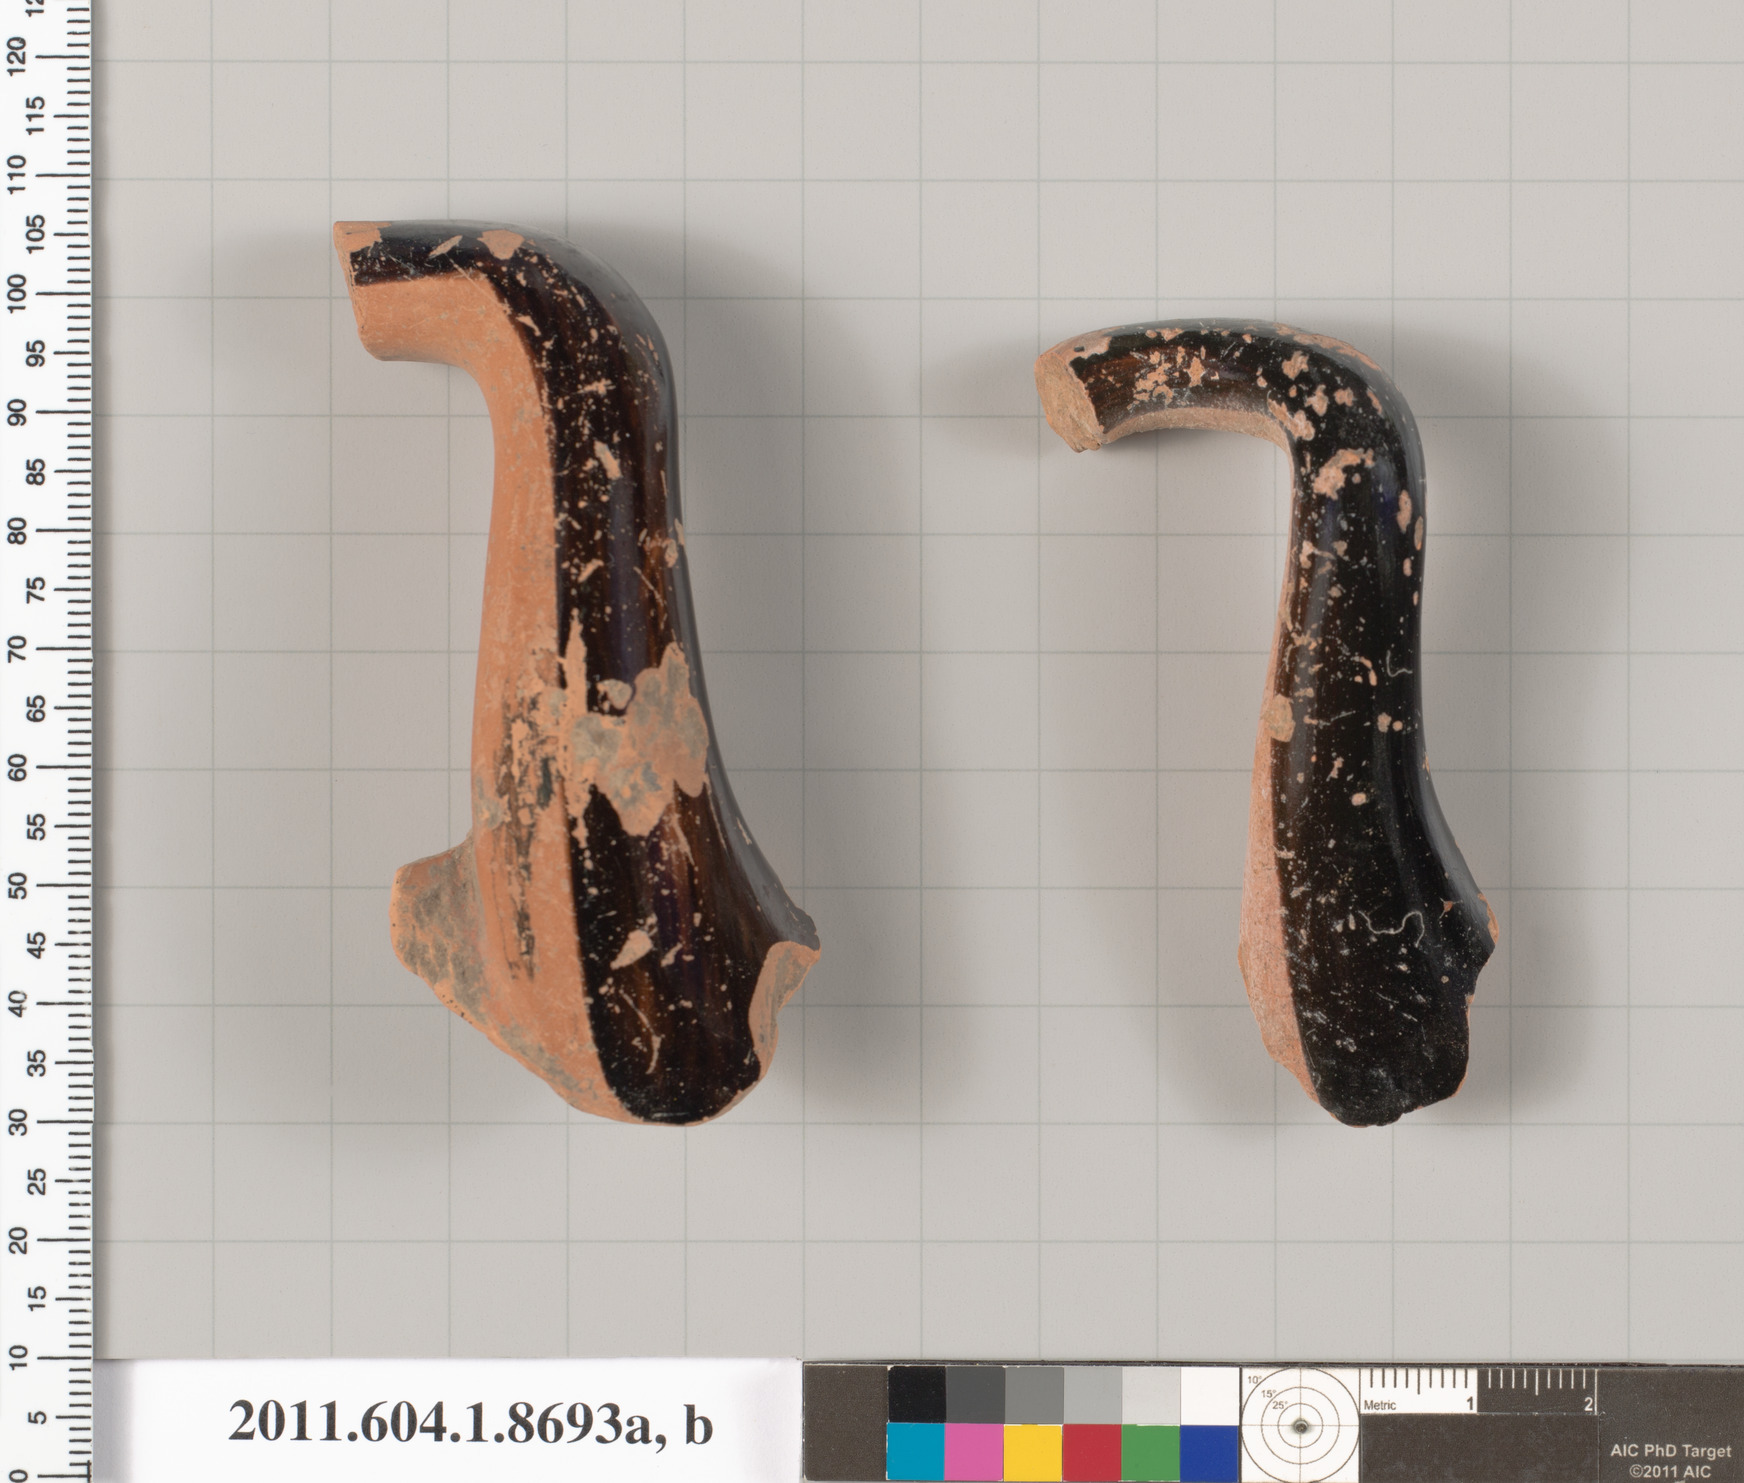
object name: kylix fragment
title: Terracotta fragments of stemless kylikes (drinking cups)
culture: greek, attic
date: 470-450 BCE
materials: terracotta